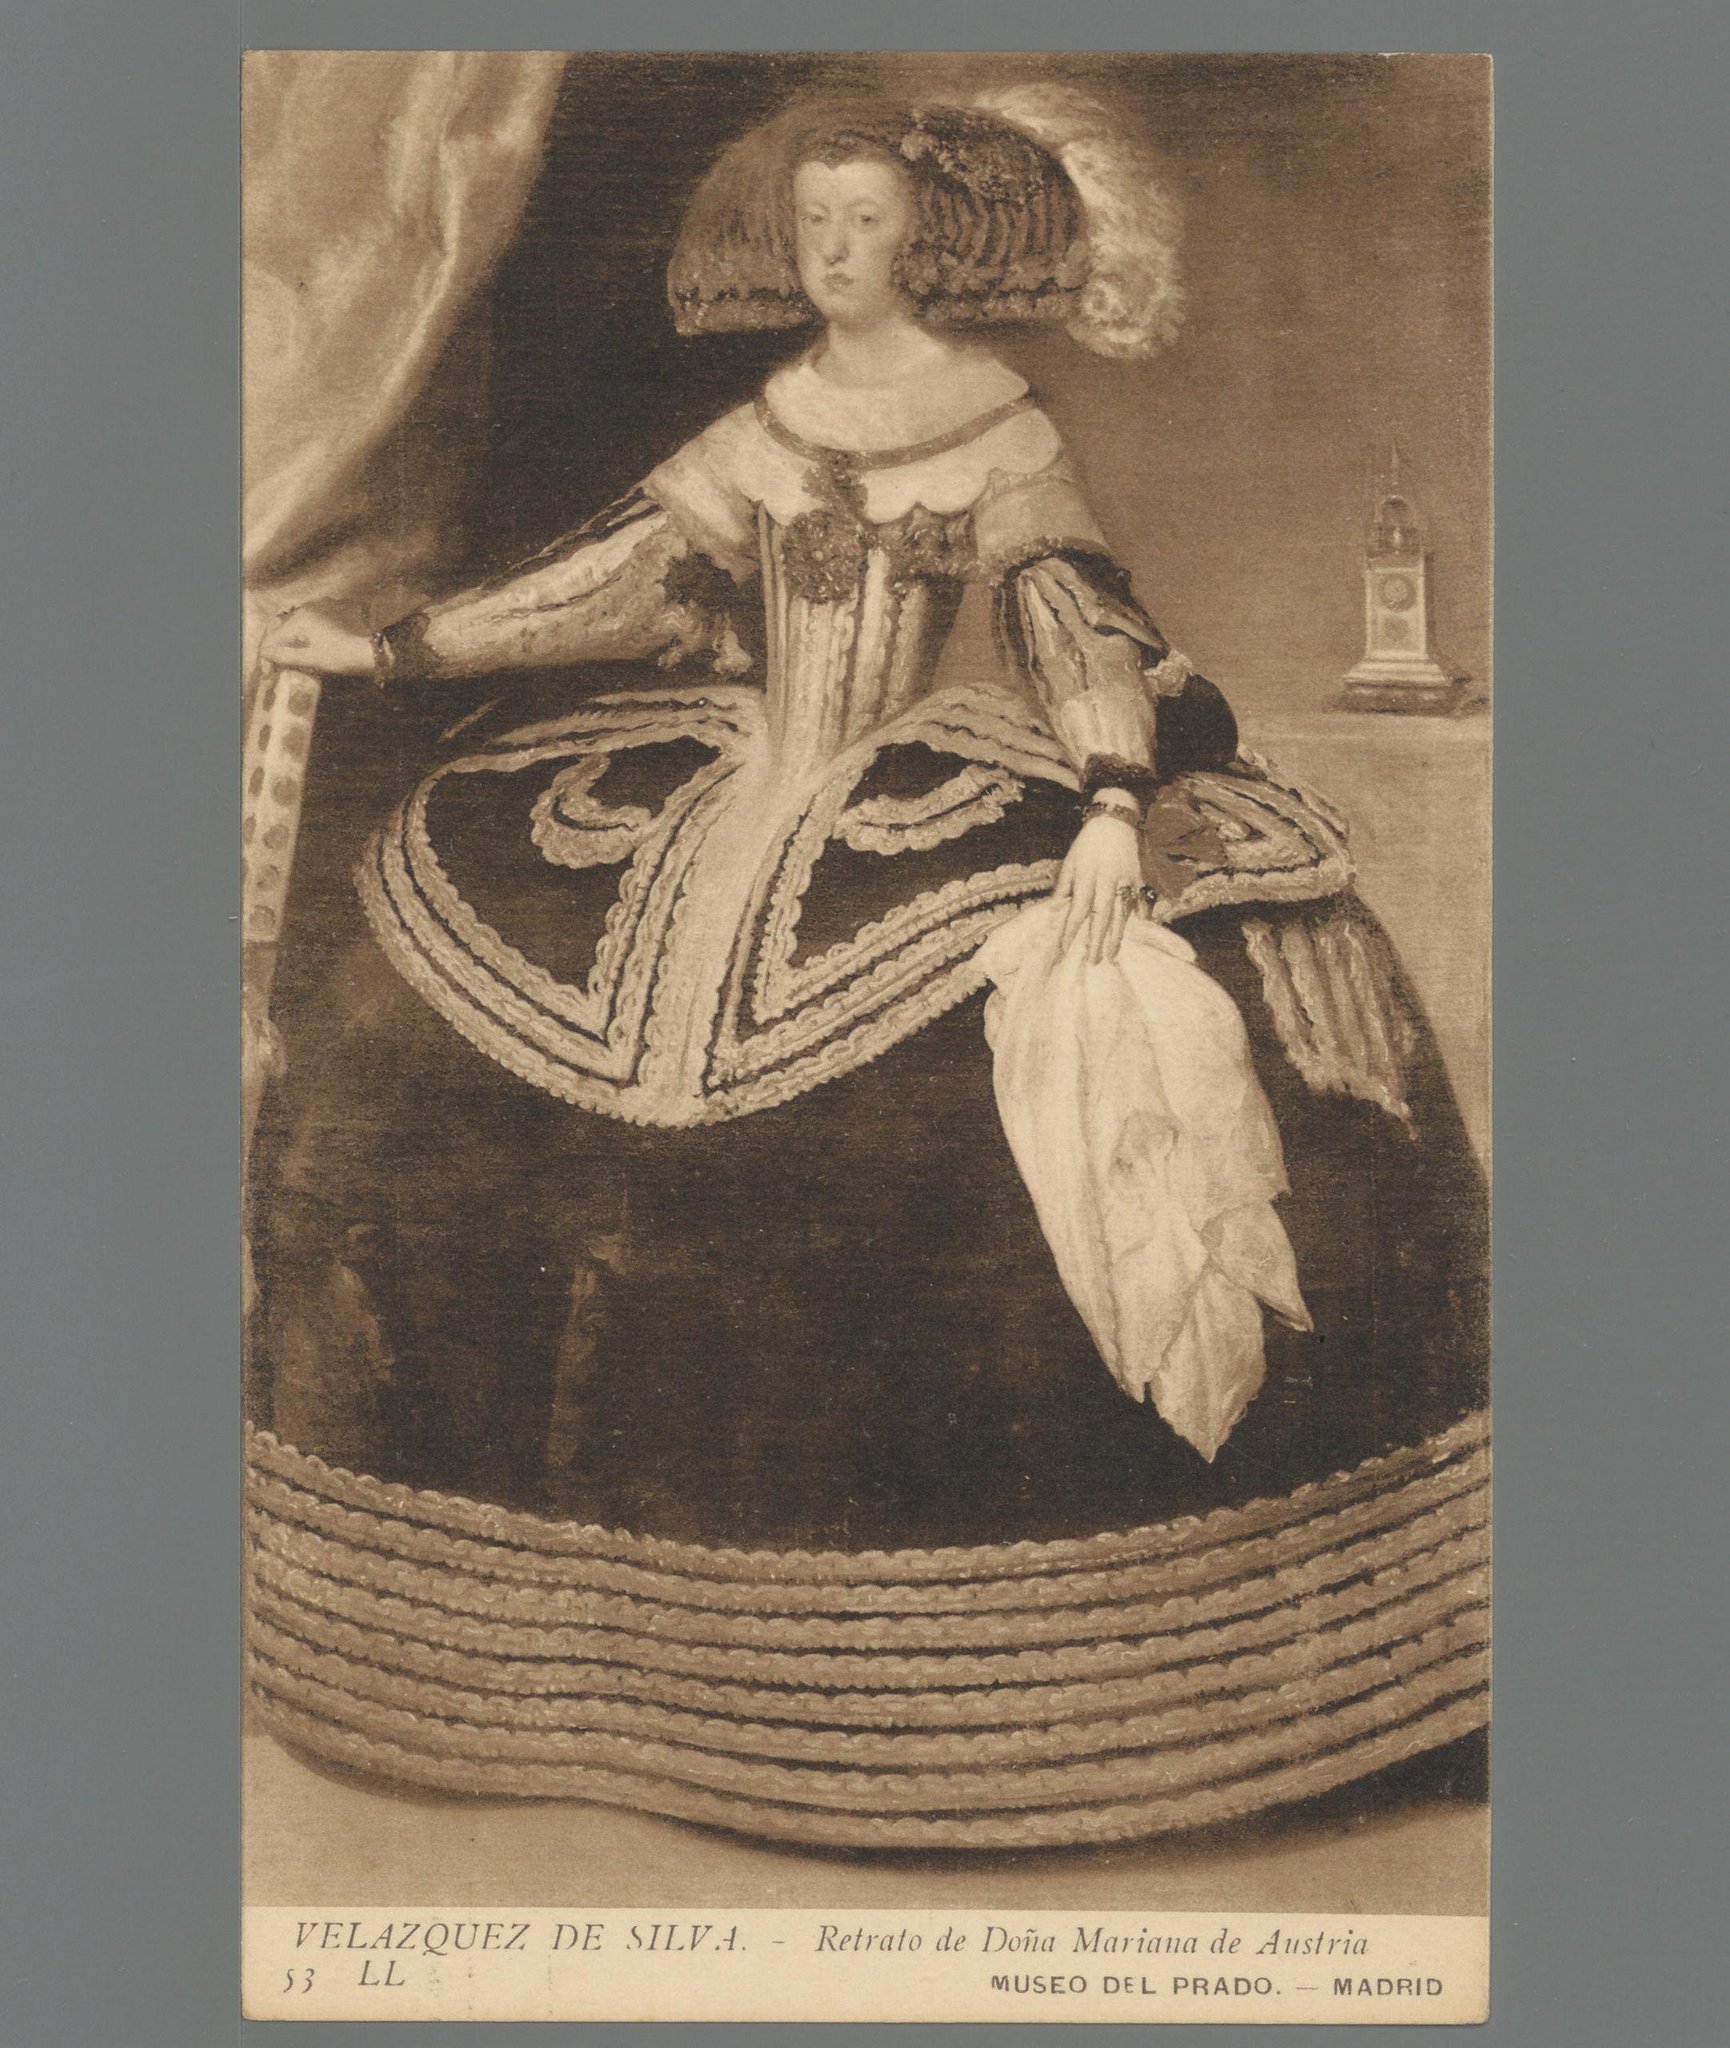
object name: photomechanical print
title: Retrato de Doña Mariana de Austria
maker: diego rodriguez de silva y velázquez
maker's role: painter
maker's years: 1599-1660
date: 1905-1920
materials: cardboard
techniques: photograph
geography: madrid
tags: vienna, maria anna van oostenrijk (koningin van spanje), historical persons, dress, gown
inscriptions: collector's mark: ‘AFE v S’